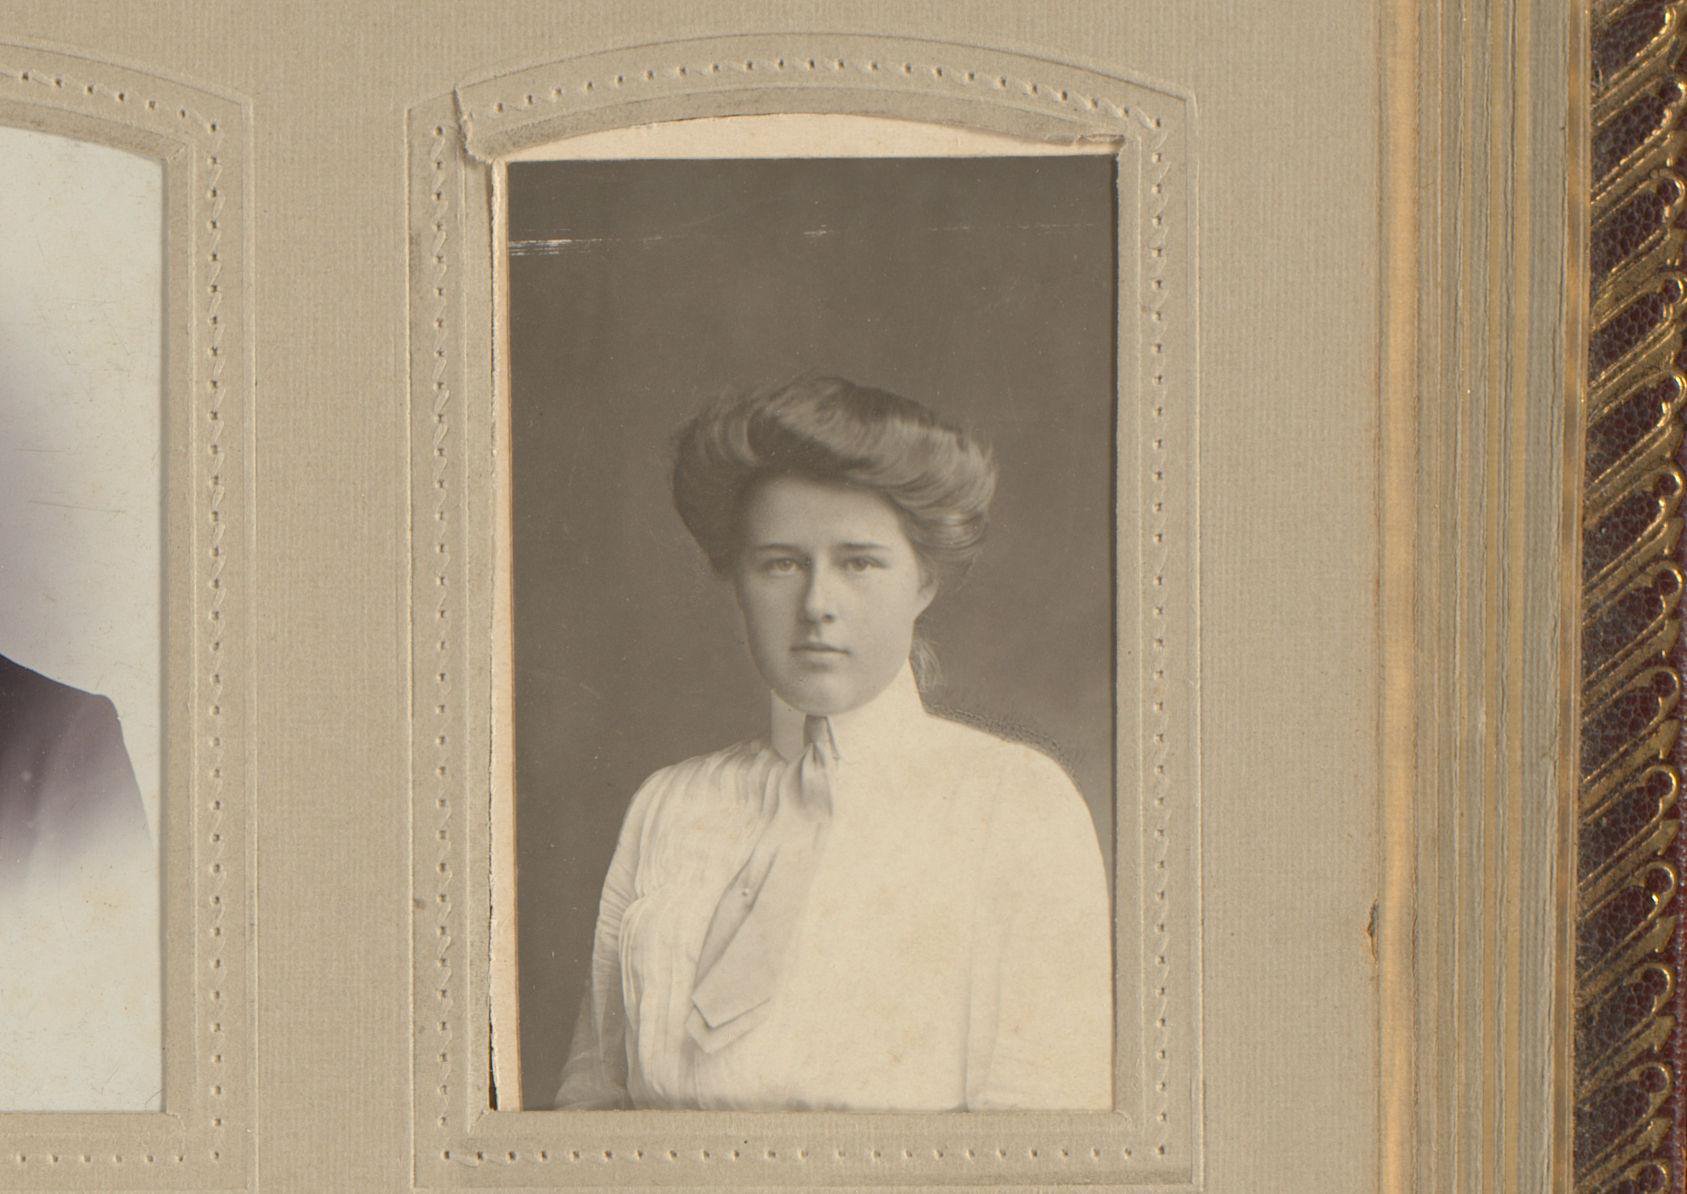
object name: photograph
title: Studioportret van een jonge vrouw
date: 1900-1920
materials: paper, photographic support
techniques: gelatin silver print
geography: netherlands